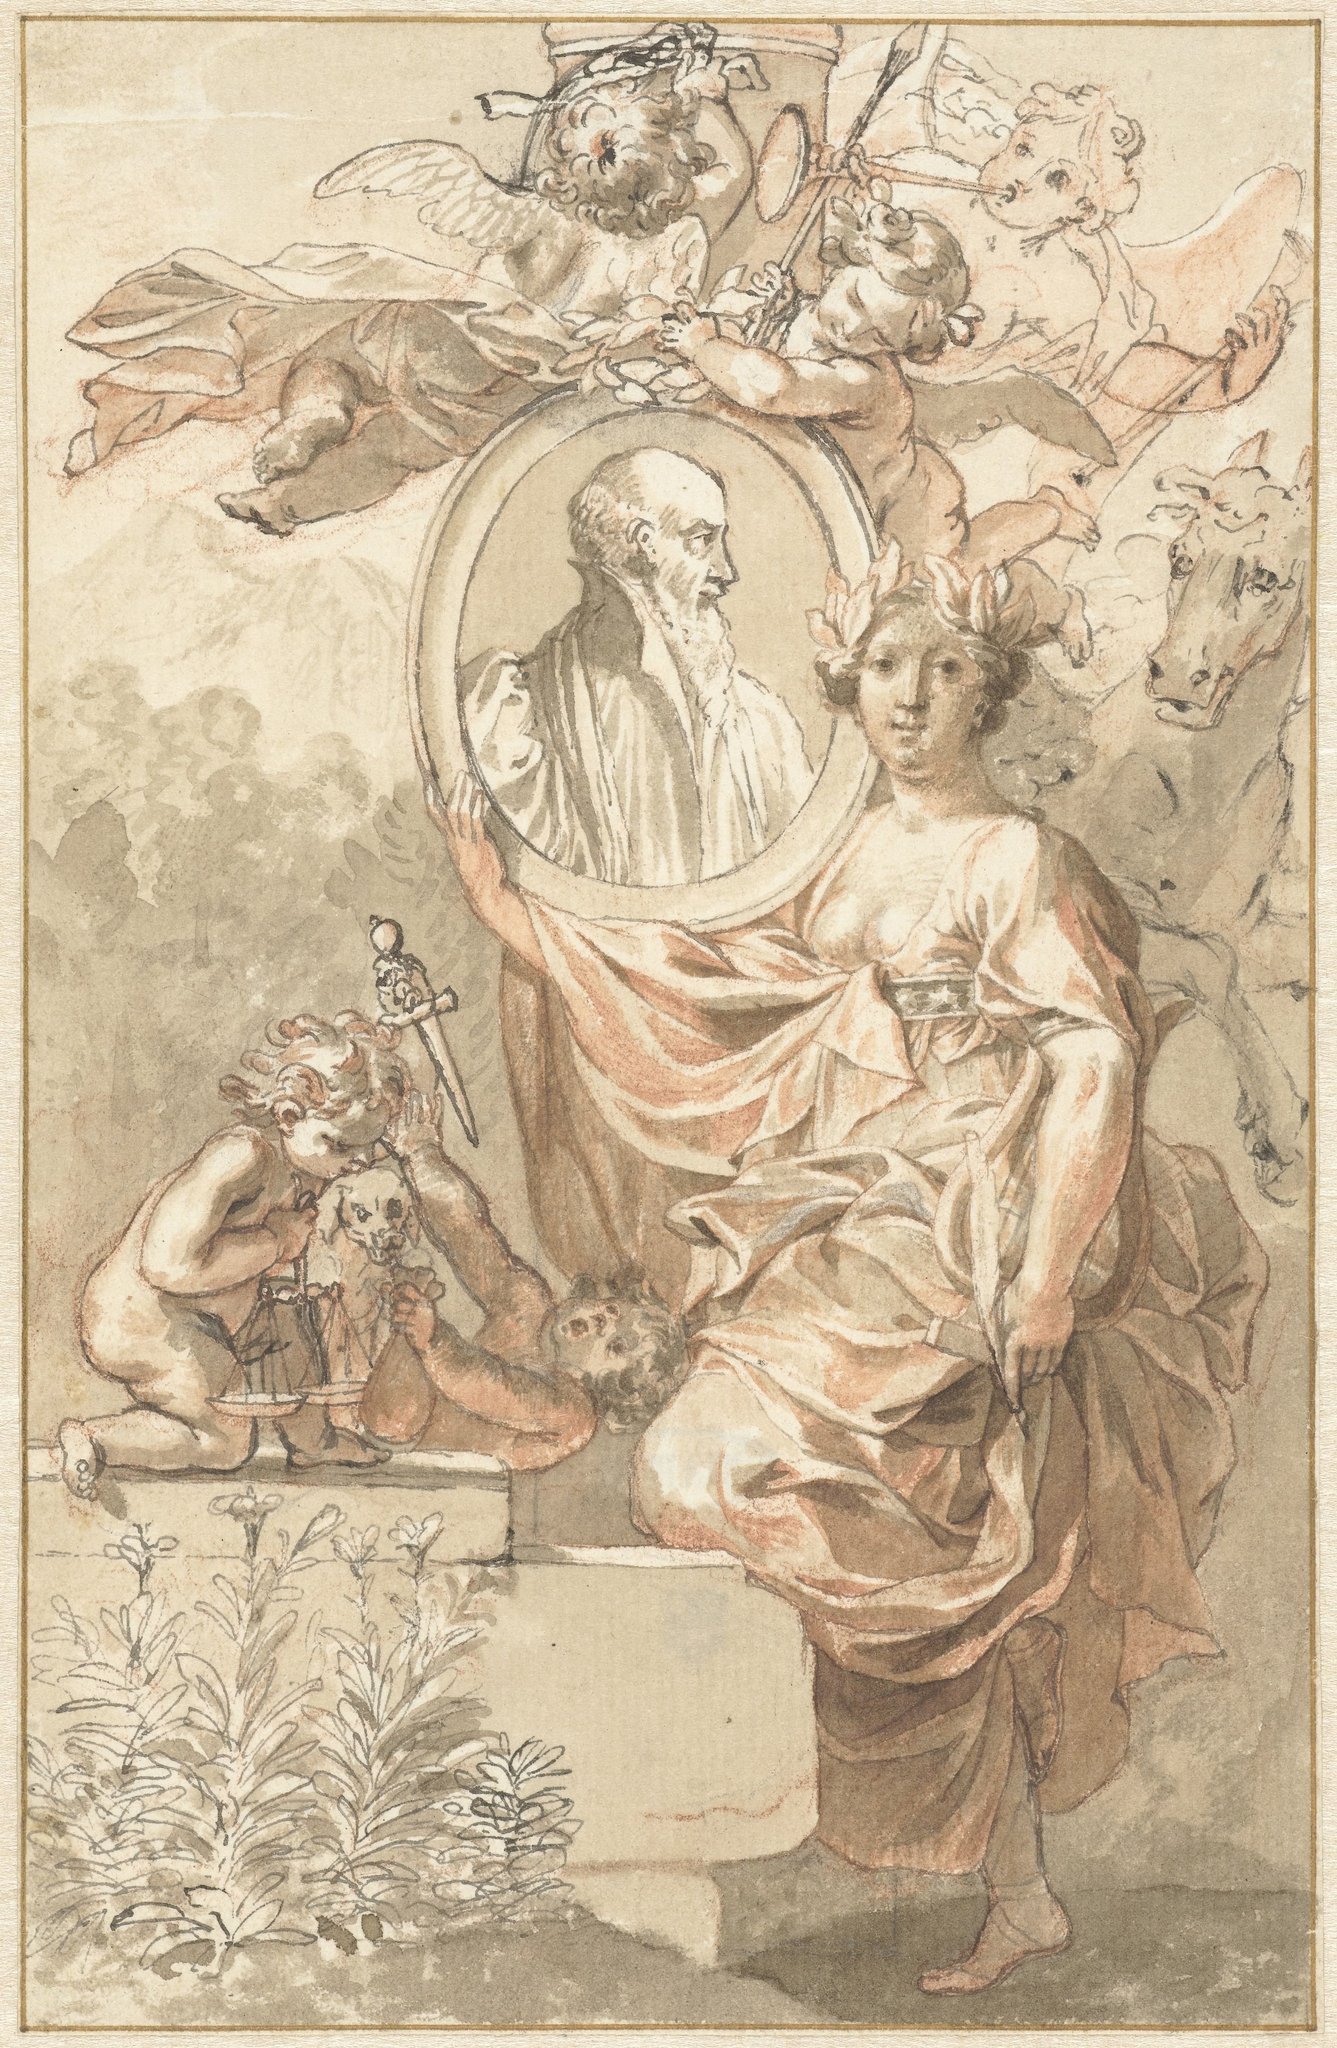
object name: drawing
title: Ontwerp voor het titelblad van Sannisarius' Arcadia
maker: jan wandelaar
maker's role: draughtsman, print maker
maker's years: 1690-1759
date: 1700-1759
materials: ink, paper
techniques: brush, pen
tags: rome, jacopo sannazaro, historical persons, title-page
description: Titelblad van de vertaling, door Vlaming, van 'Arcadia' van Jacopo Sanazzaro (1456-1530).